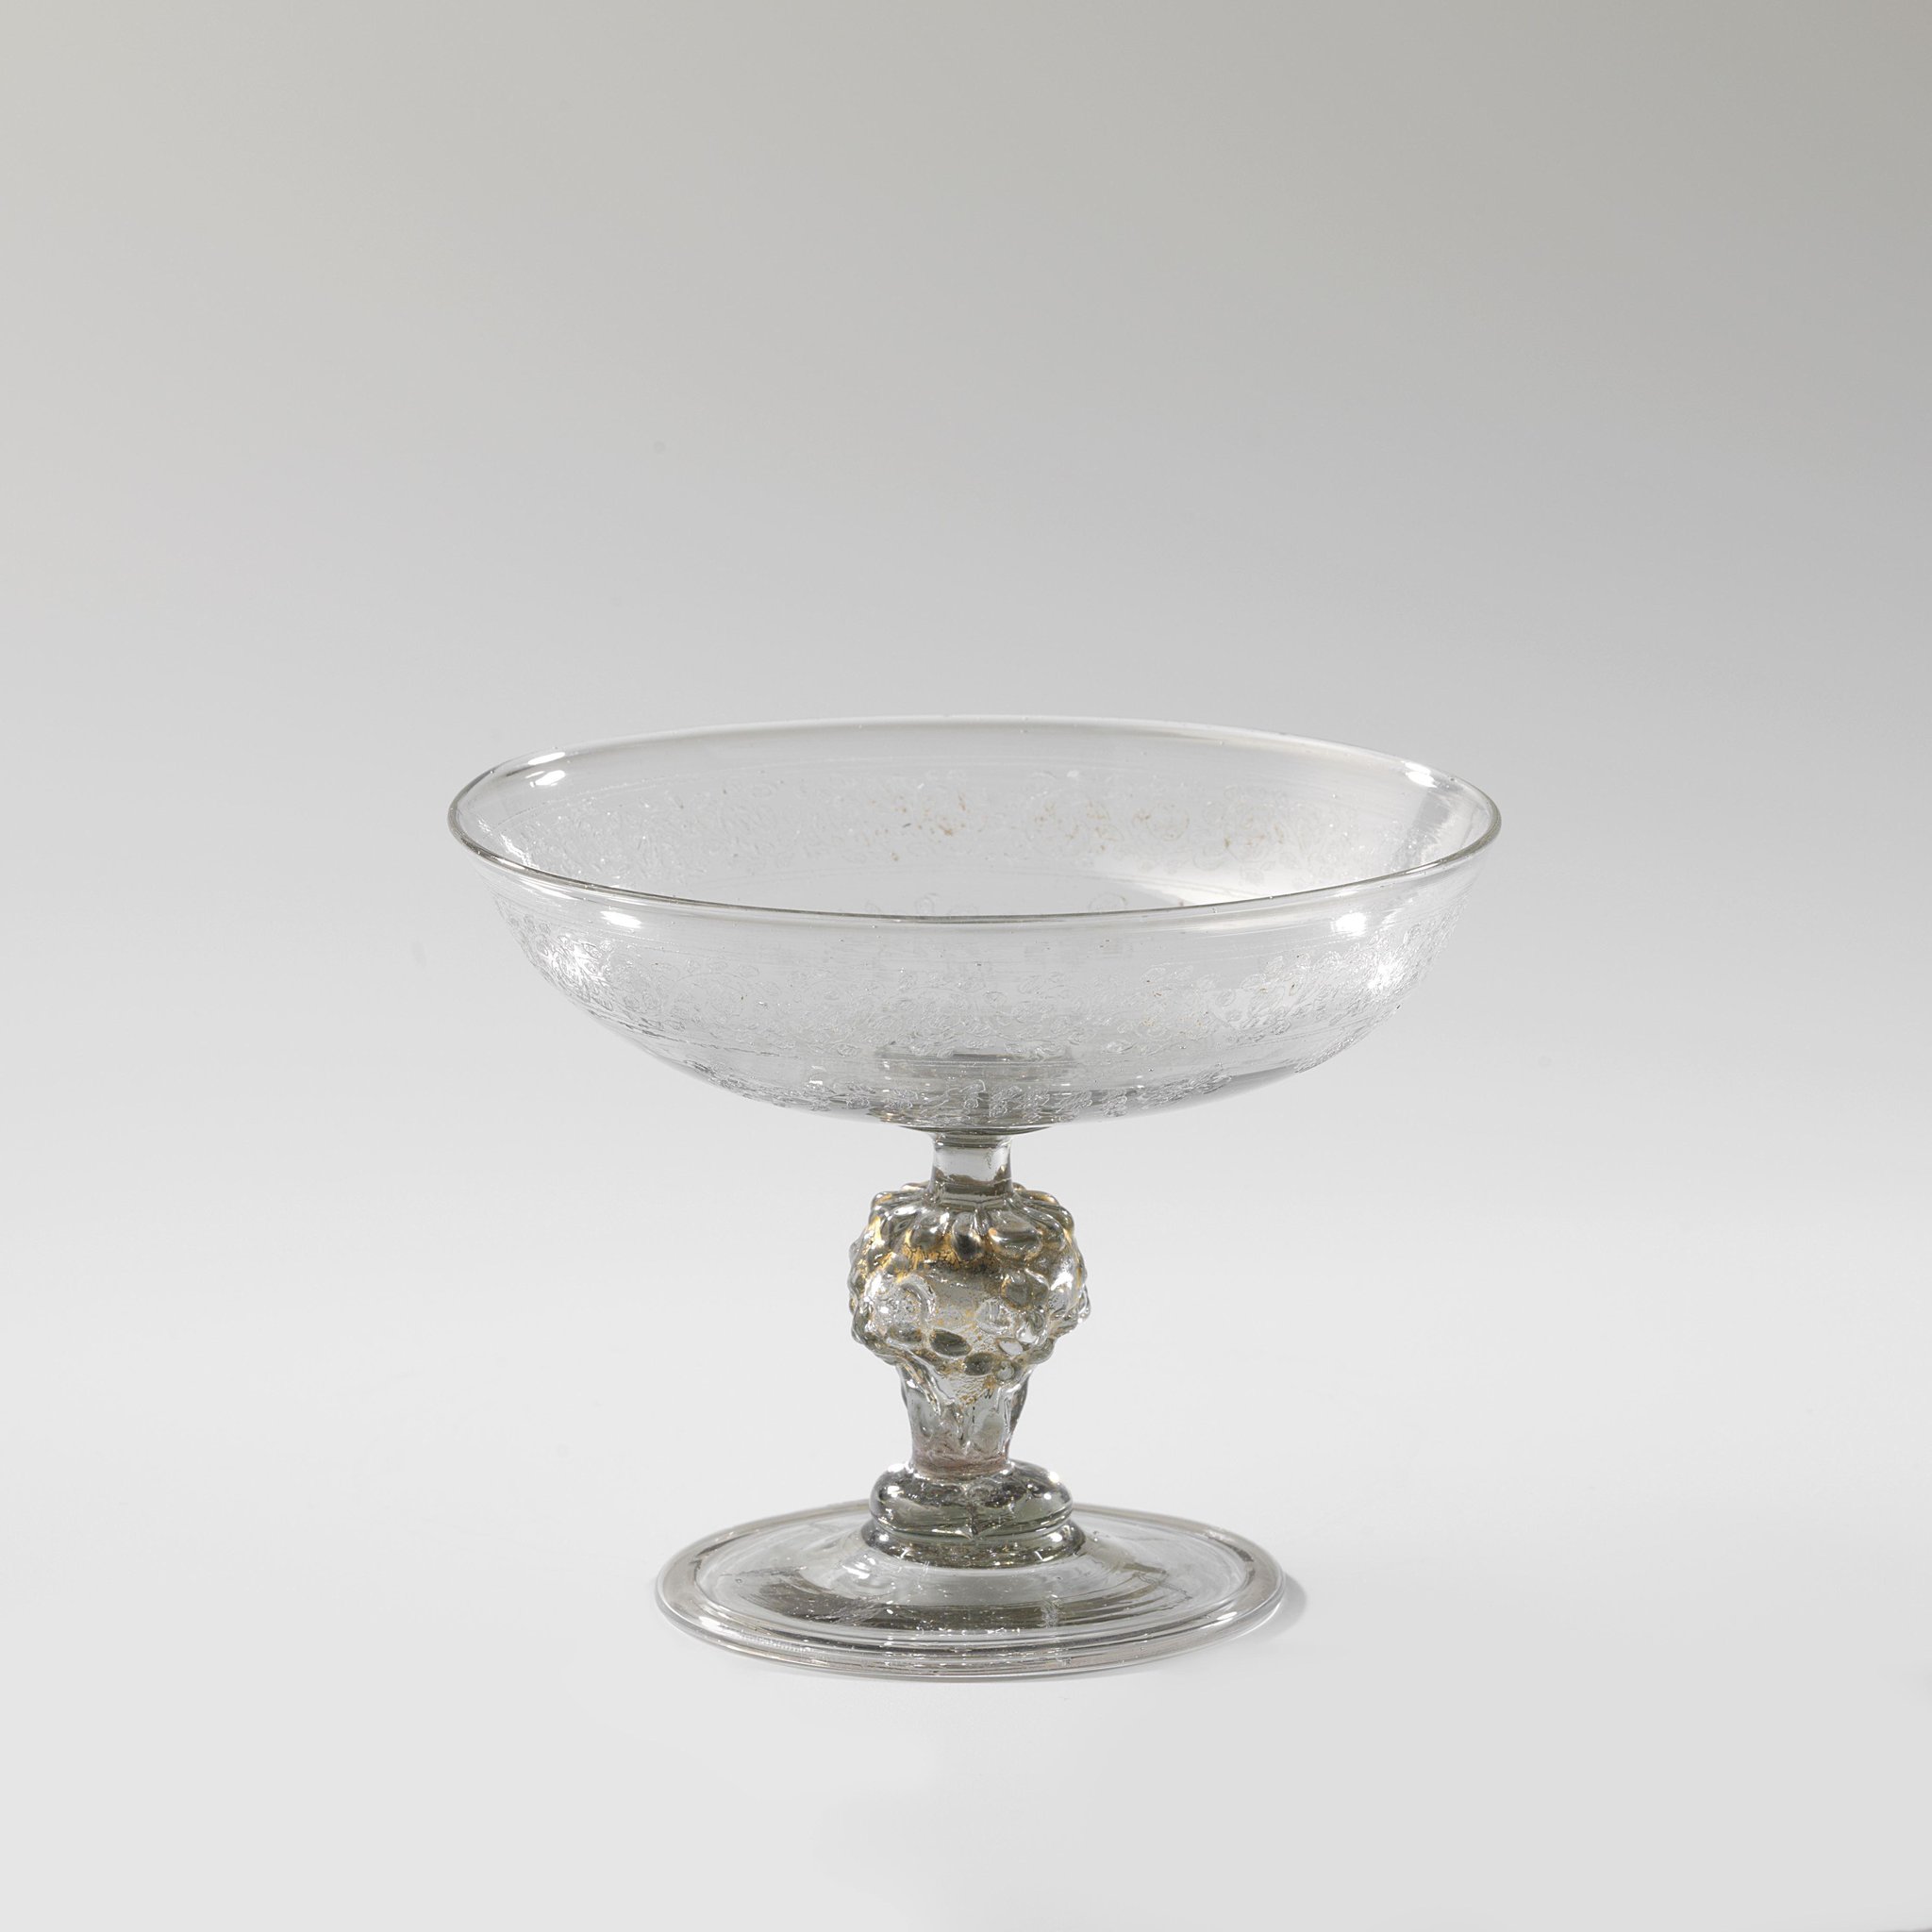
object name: tazza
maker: Anonymous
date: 1600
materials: glass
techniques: diamond point engraving, façon de venise, gilding, glassblowing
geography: northern netherlands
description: Platte voet met omgeslagen rand en pontilmerk. Balustervormige stam, in de vorm geblazen in een motief van twee leeuwenmaskers en twee rozetten. Komvormige kelk. Op de kelk zijn twee banden met bladranken gegraveerd. Tussen de banden zijn twee takken met elk drie oranjeappels en twee bloemtakken afgebeeld.